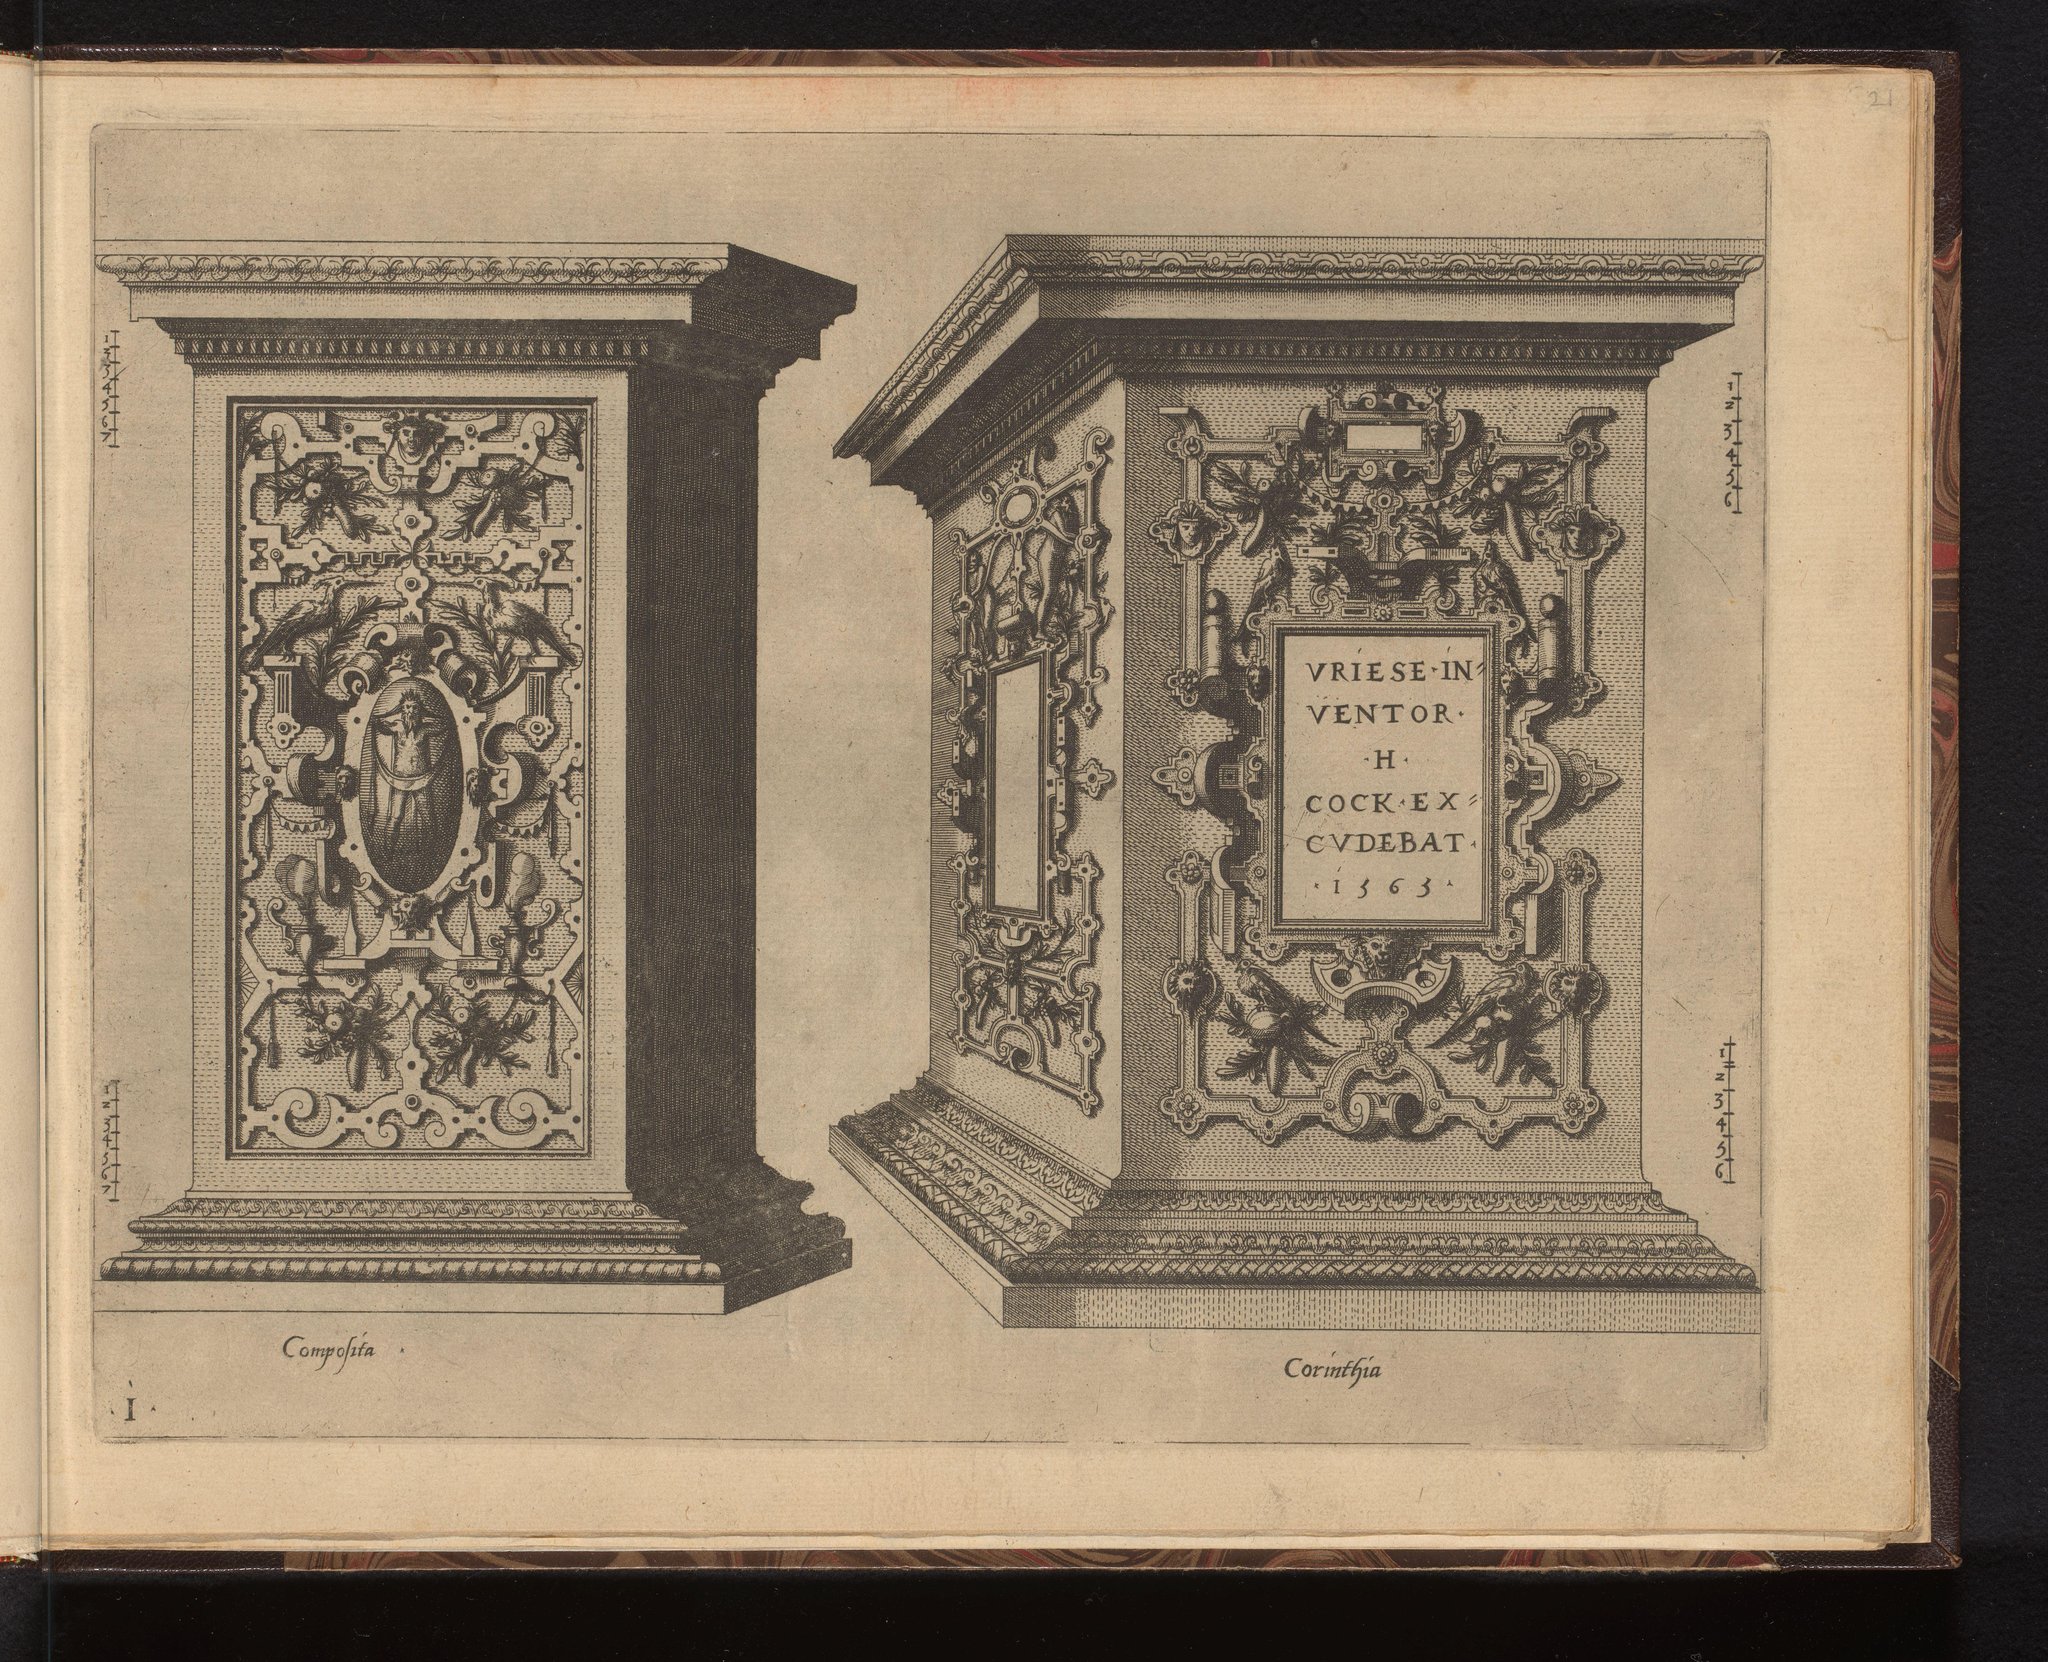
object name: ornament print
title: Das ander Buech gemacht auff die zway Colonnen, Corinthia und Composita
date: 1565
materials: paper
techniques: etching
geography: antwerp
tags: composite order ~ architecture, pedestal of a piece of sculpture (perhaps in the form of a herm), corinthian order ~ architecture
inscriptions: date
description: Twee piëdestals. Links een piëdestal waarvan de voorzijde gedecoreerd is met een ovale cartouche met een man of sater, in een omlijsting van rol- en beslagwerk. Rechts een piëdestal met een rechthoekige cartouche in een omlijsting van beslagwerk op voor- en zijkant, gedecoreerd met vogels en fruittrofeeën. Op de prent is vier maal een schaalverdeling aangegeven. De prent maakt deel uit van een album.